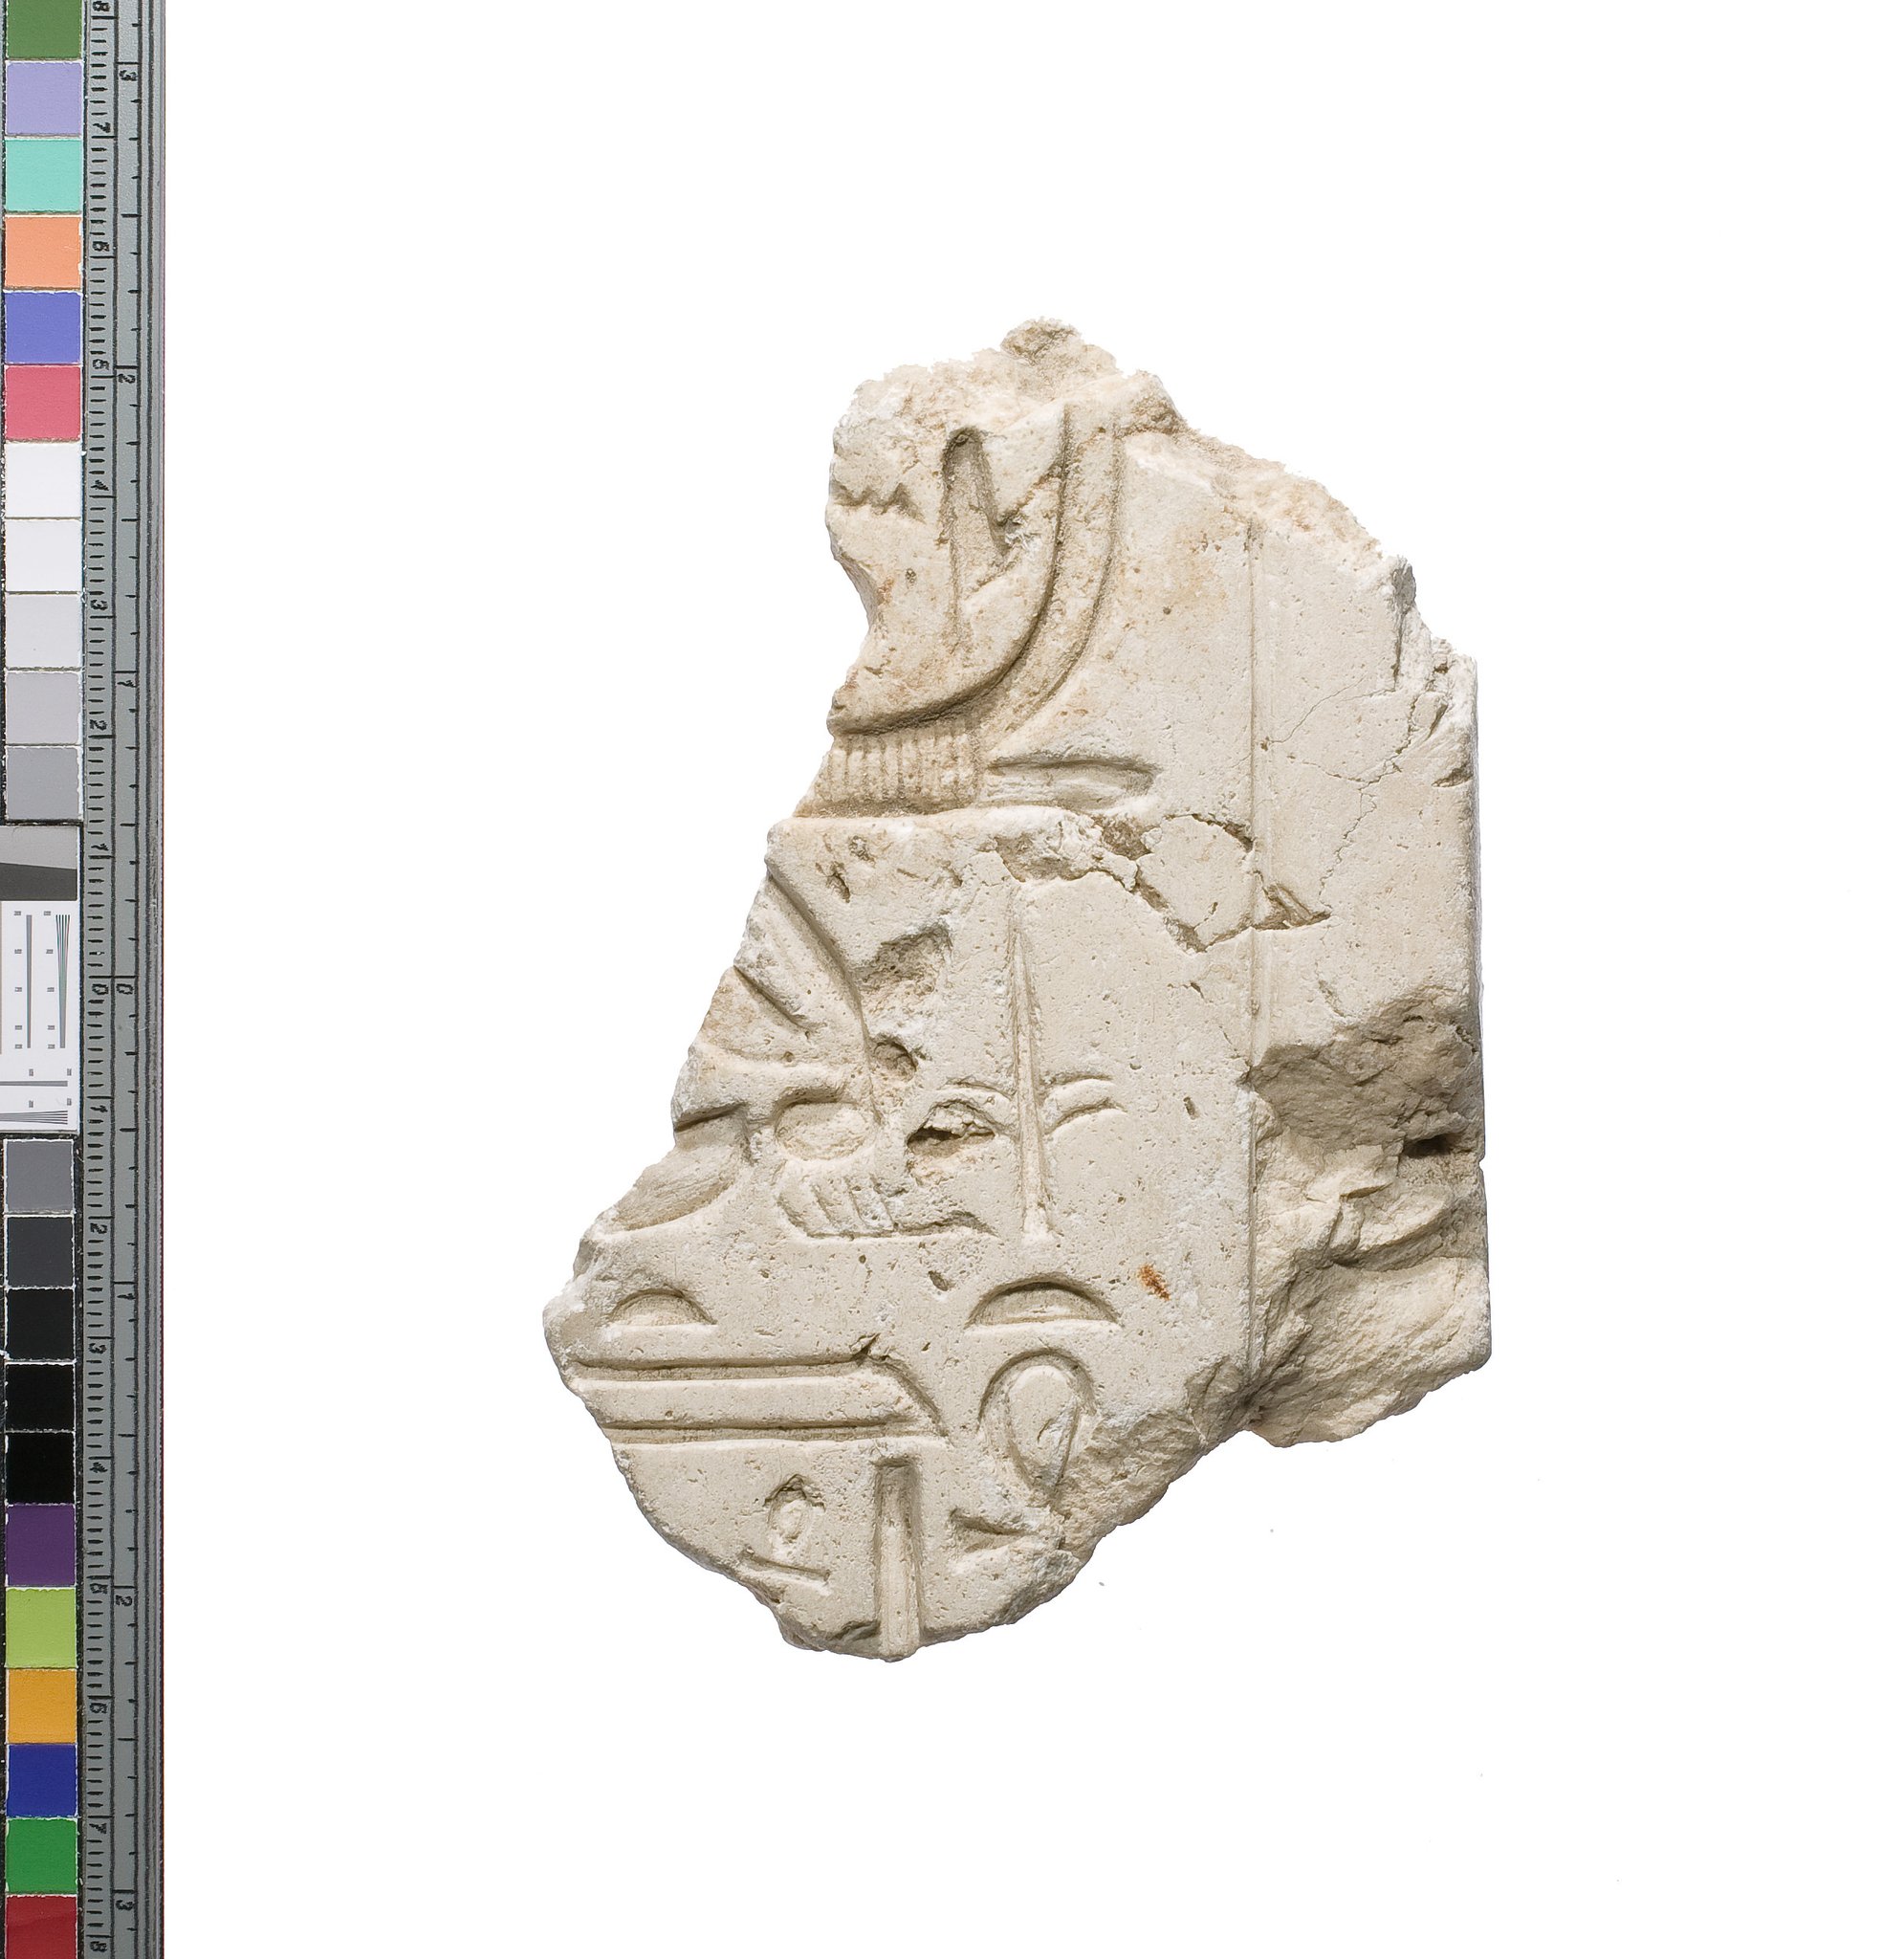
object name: inscribed fragment, aten cartouche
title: Inscribed fragment, lower end of Aten cartouche, swt bity titular of king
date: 1353-1336 BCE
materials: limestone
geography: egypt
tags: cartouches,hieroglyphs